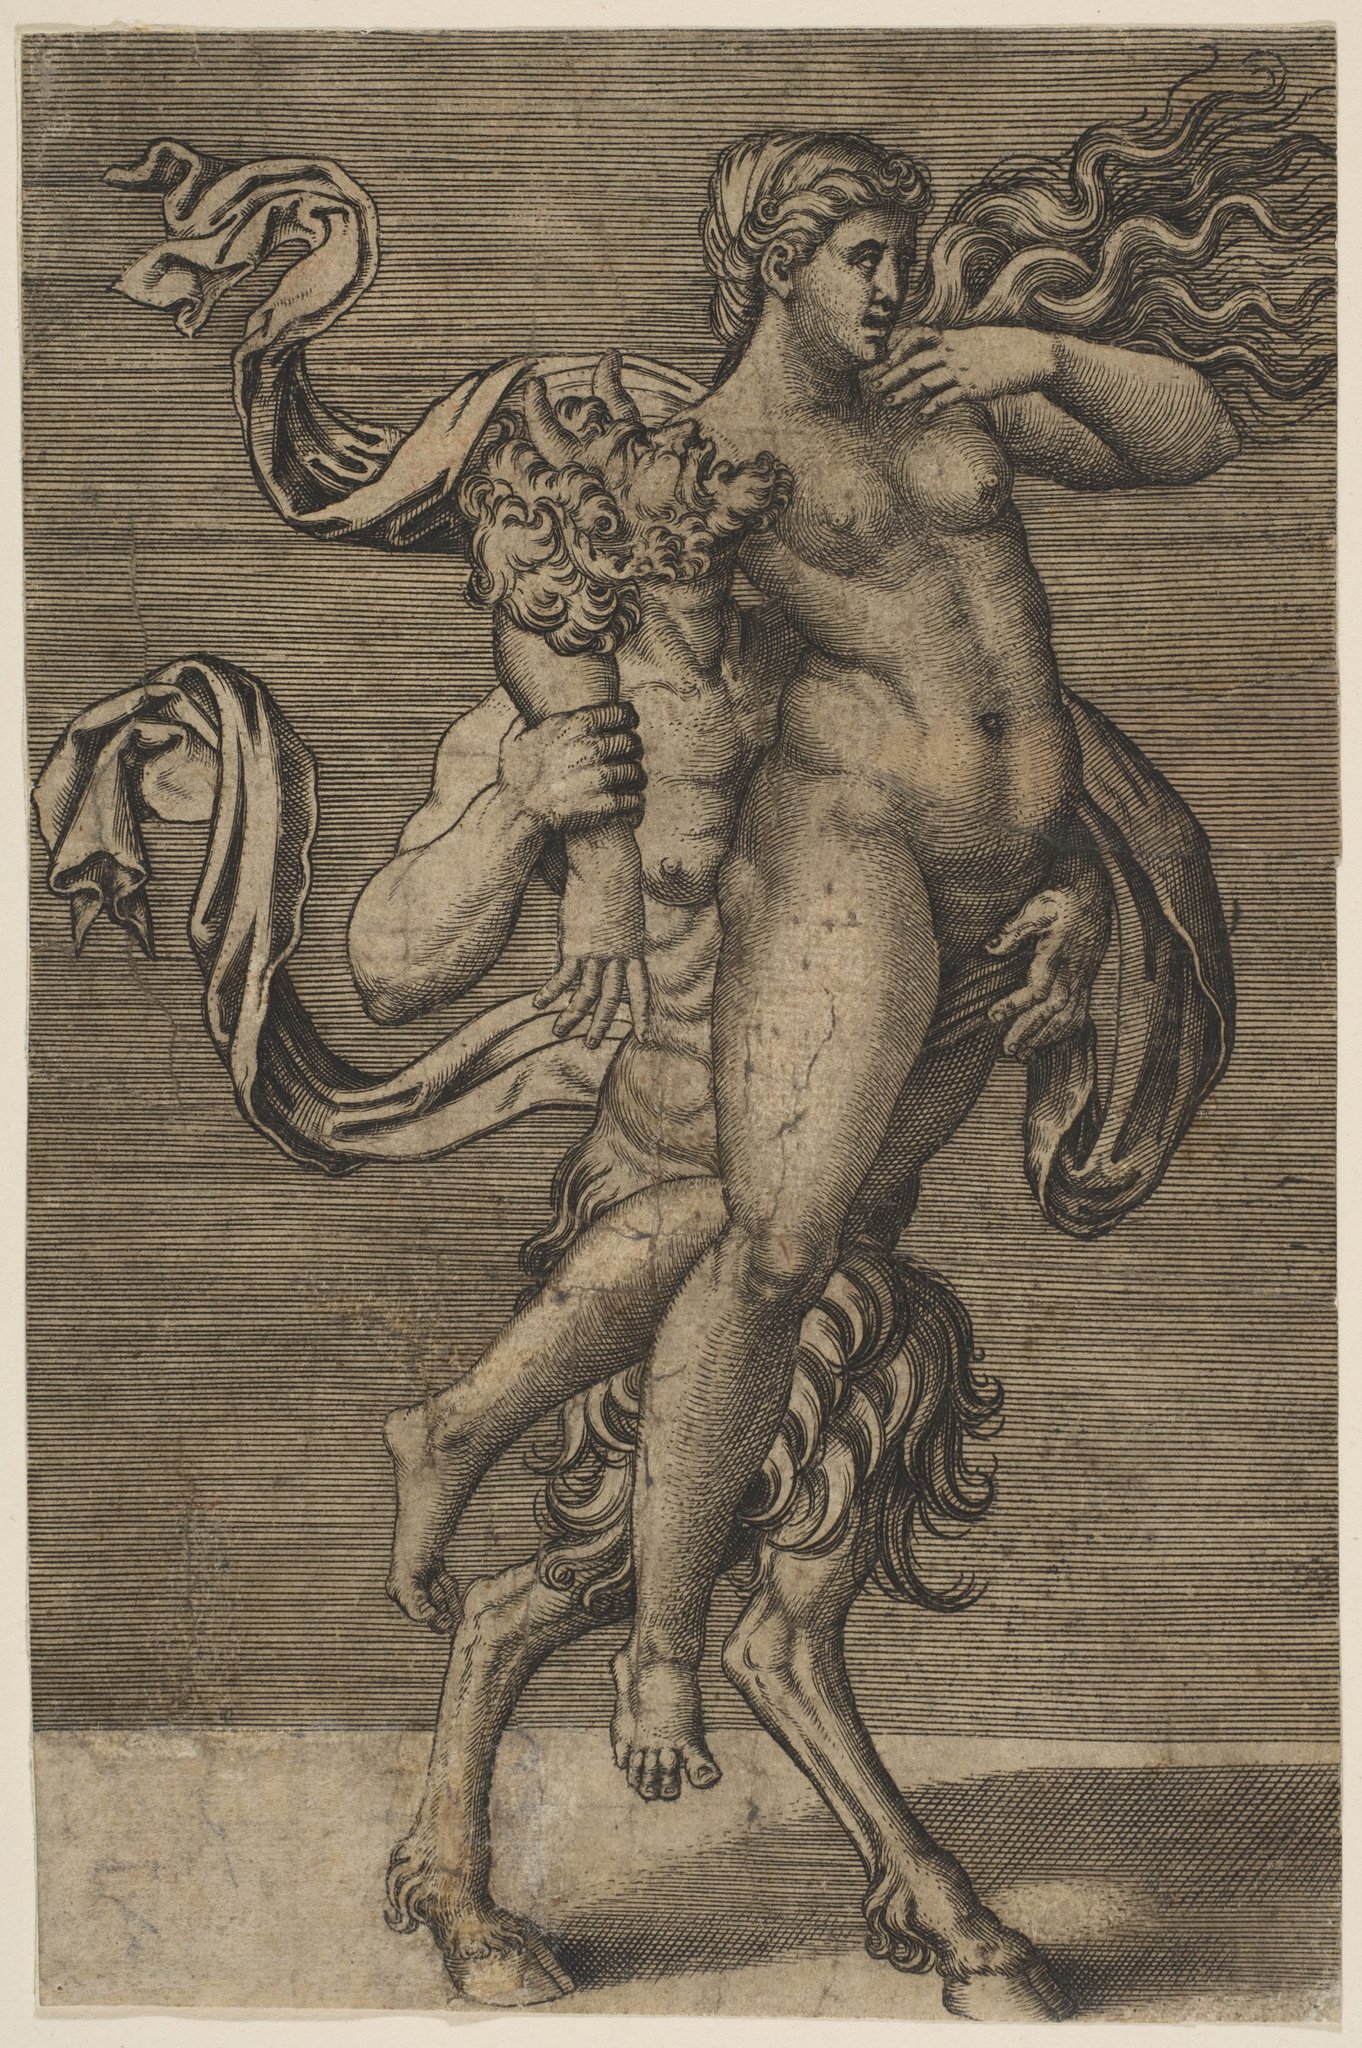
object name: print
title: Satyr carrying a nymph restraining her right arm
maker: marco dente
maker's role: artist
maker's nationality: italian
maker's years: 1515-1527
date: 1515-1527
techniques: engraving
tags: nymphs,satyrs